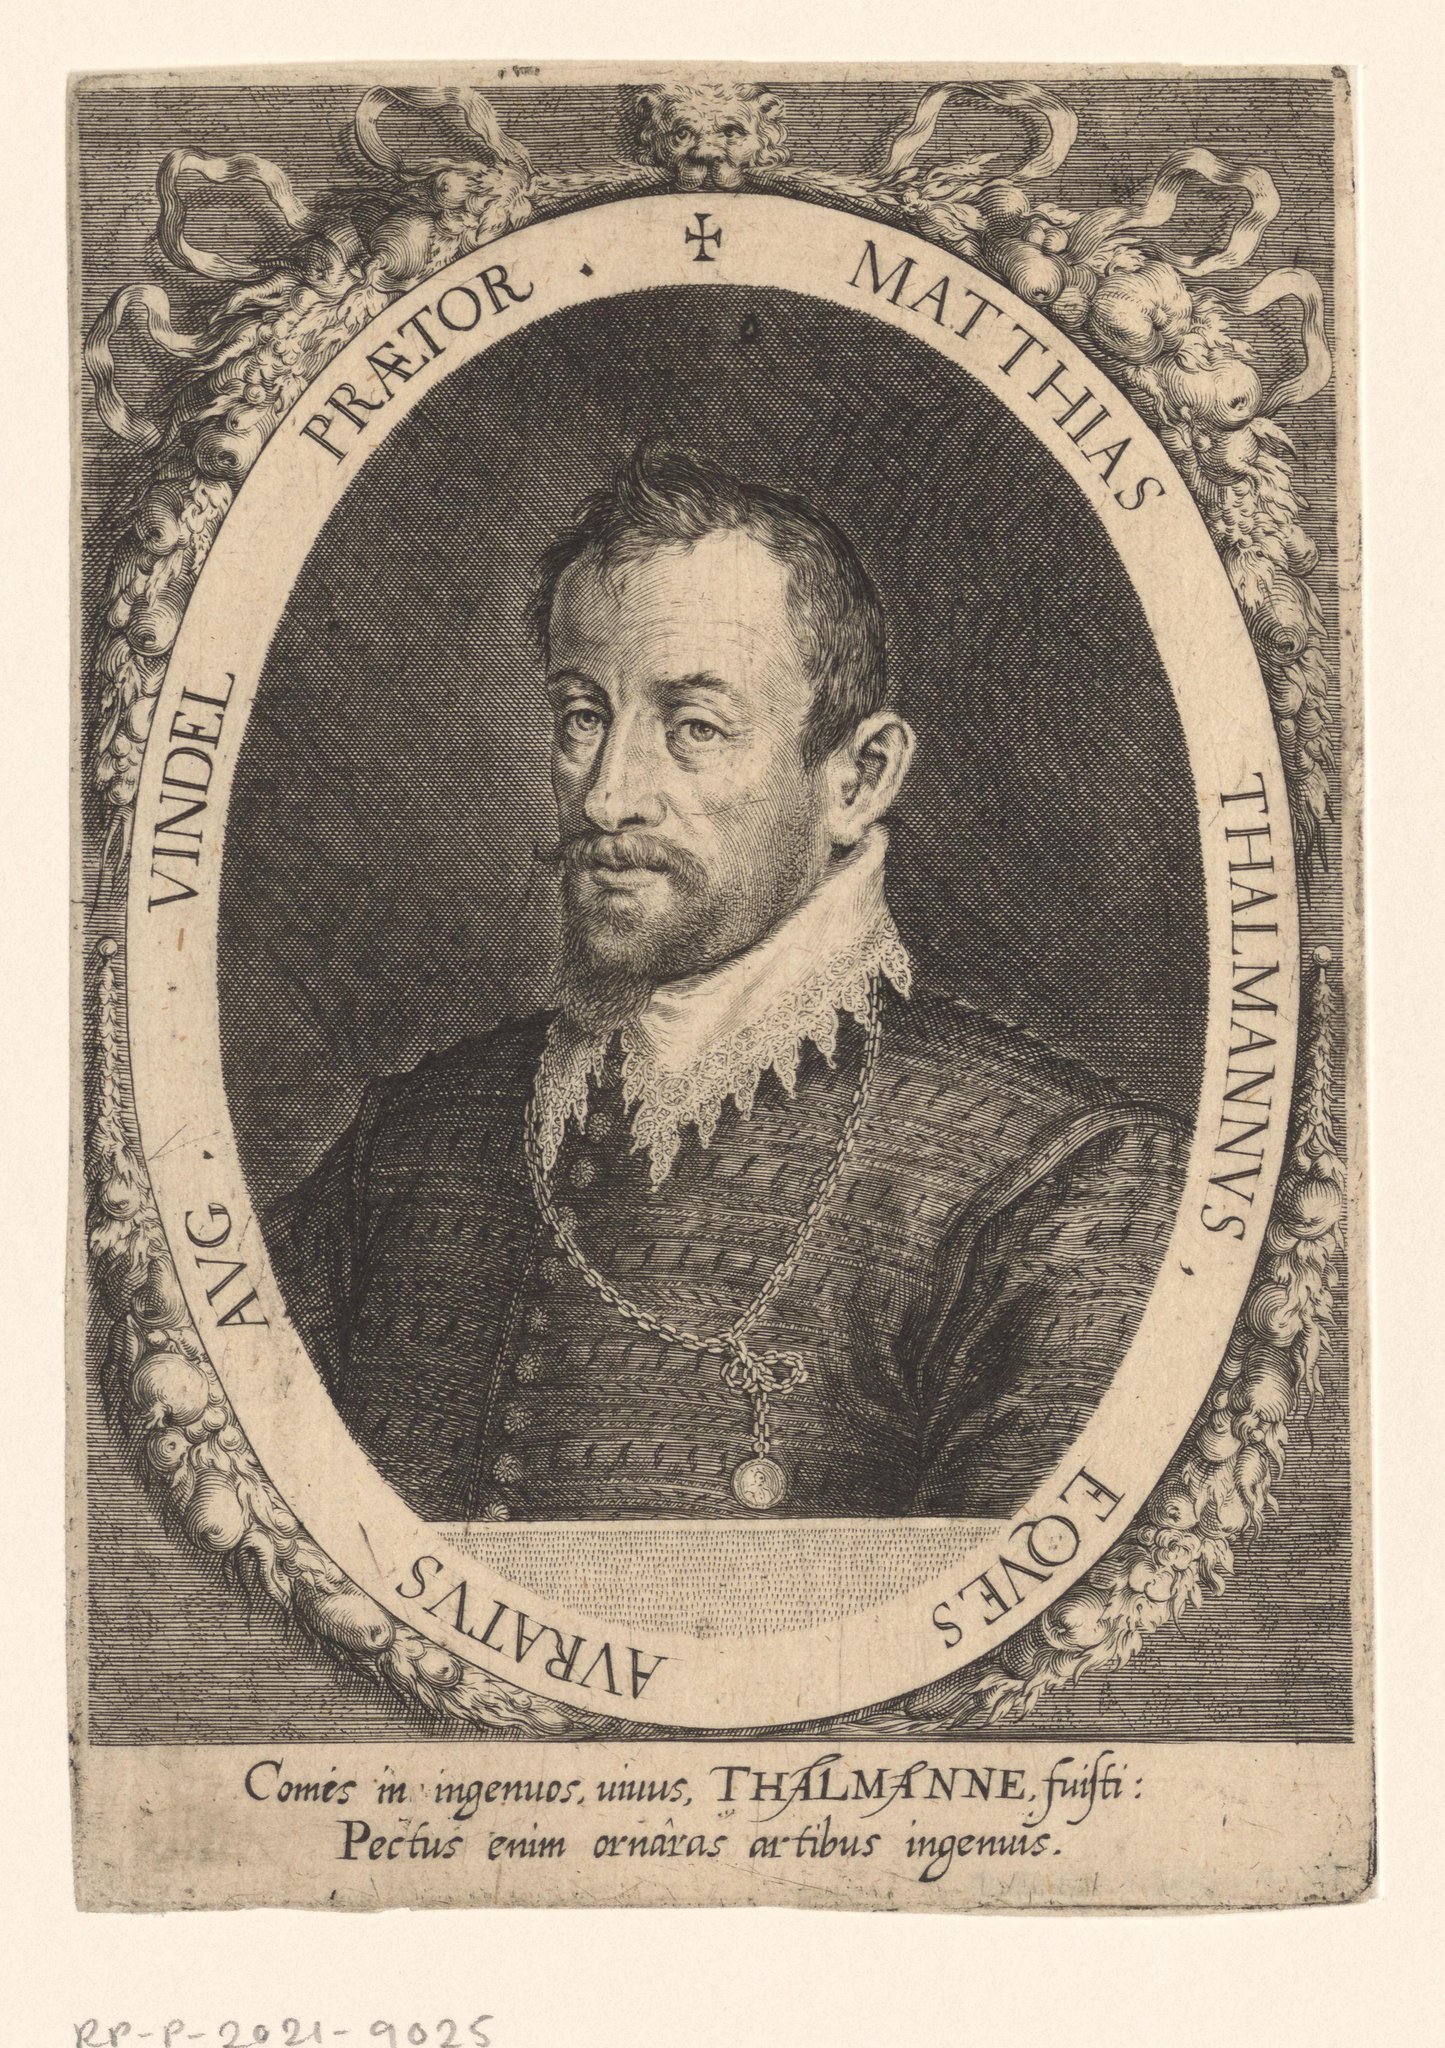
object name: print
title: Portret van Matthias Thalmann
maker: Anonymous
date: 1600-1649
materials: paper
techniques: engraving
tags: historical persons